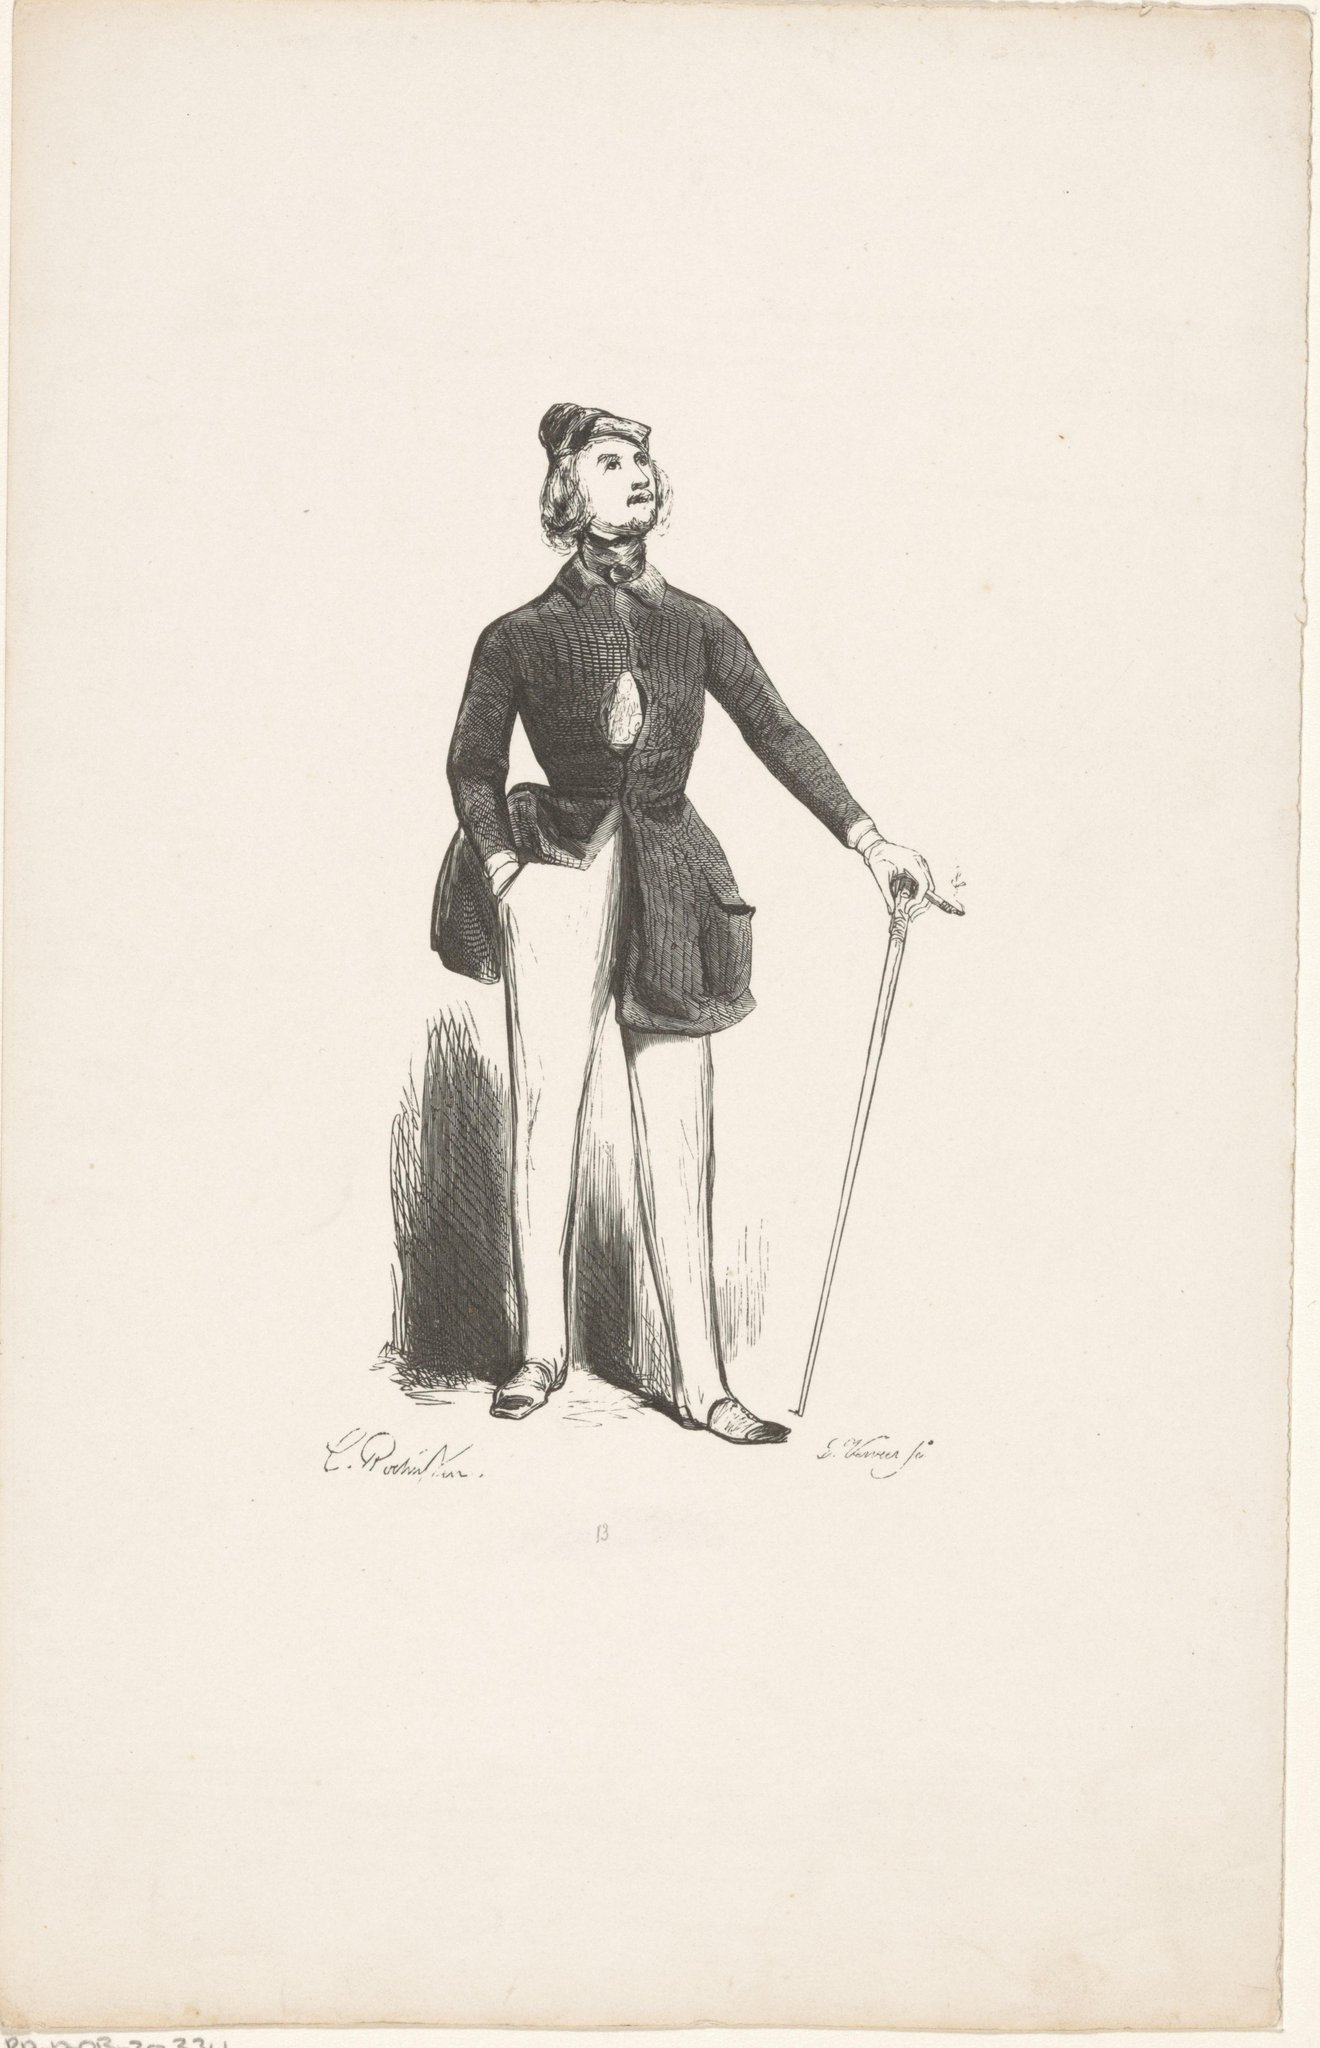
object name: print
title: Man met een wandelstok en een sigaar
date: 1836-1900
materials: paper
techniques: engraving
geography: the hague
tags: cigar, walking-stick, staff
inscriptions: collector's mark: Lugt 2228